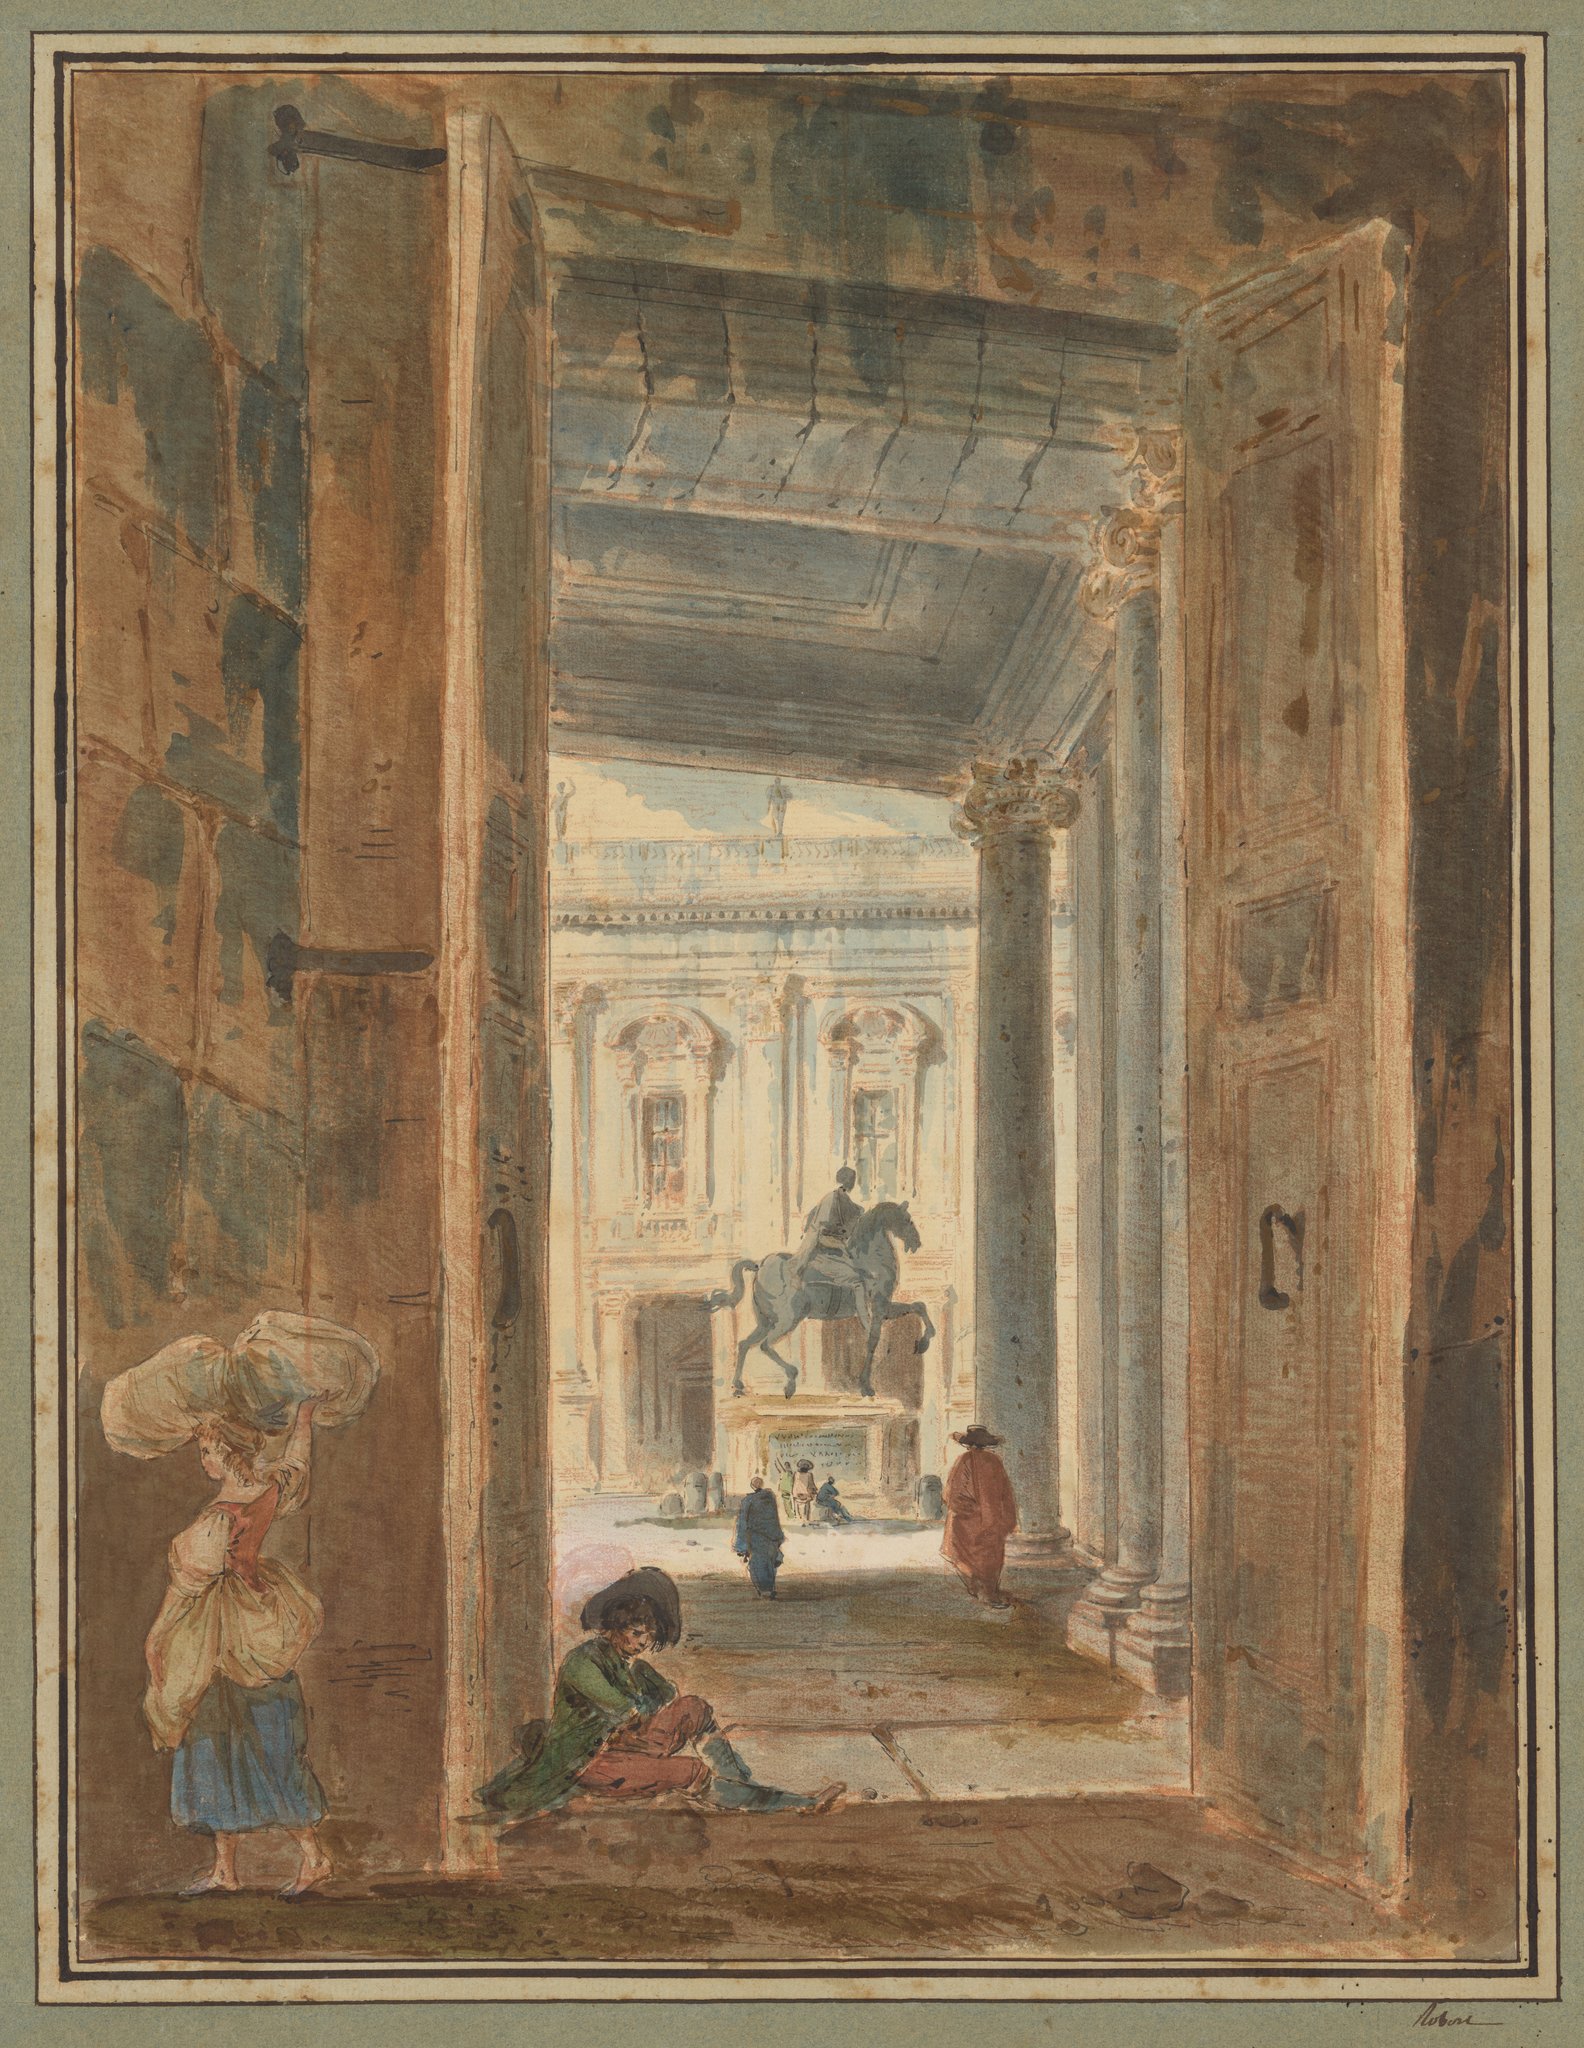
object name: drawing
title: View of the Campidoglio with the Statue of Marcus Aurelius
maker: hubert robert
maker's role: artist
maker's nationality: french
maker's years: 1733-1808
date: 1762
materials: chalk, ink, watercolor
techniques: brush, printmaking, pen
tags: human figures,sculpture,doors